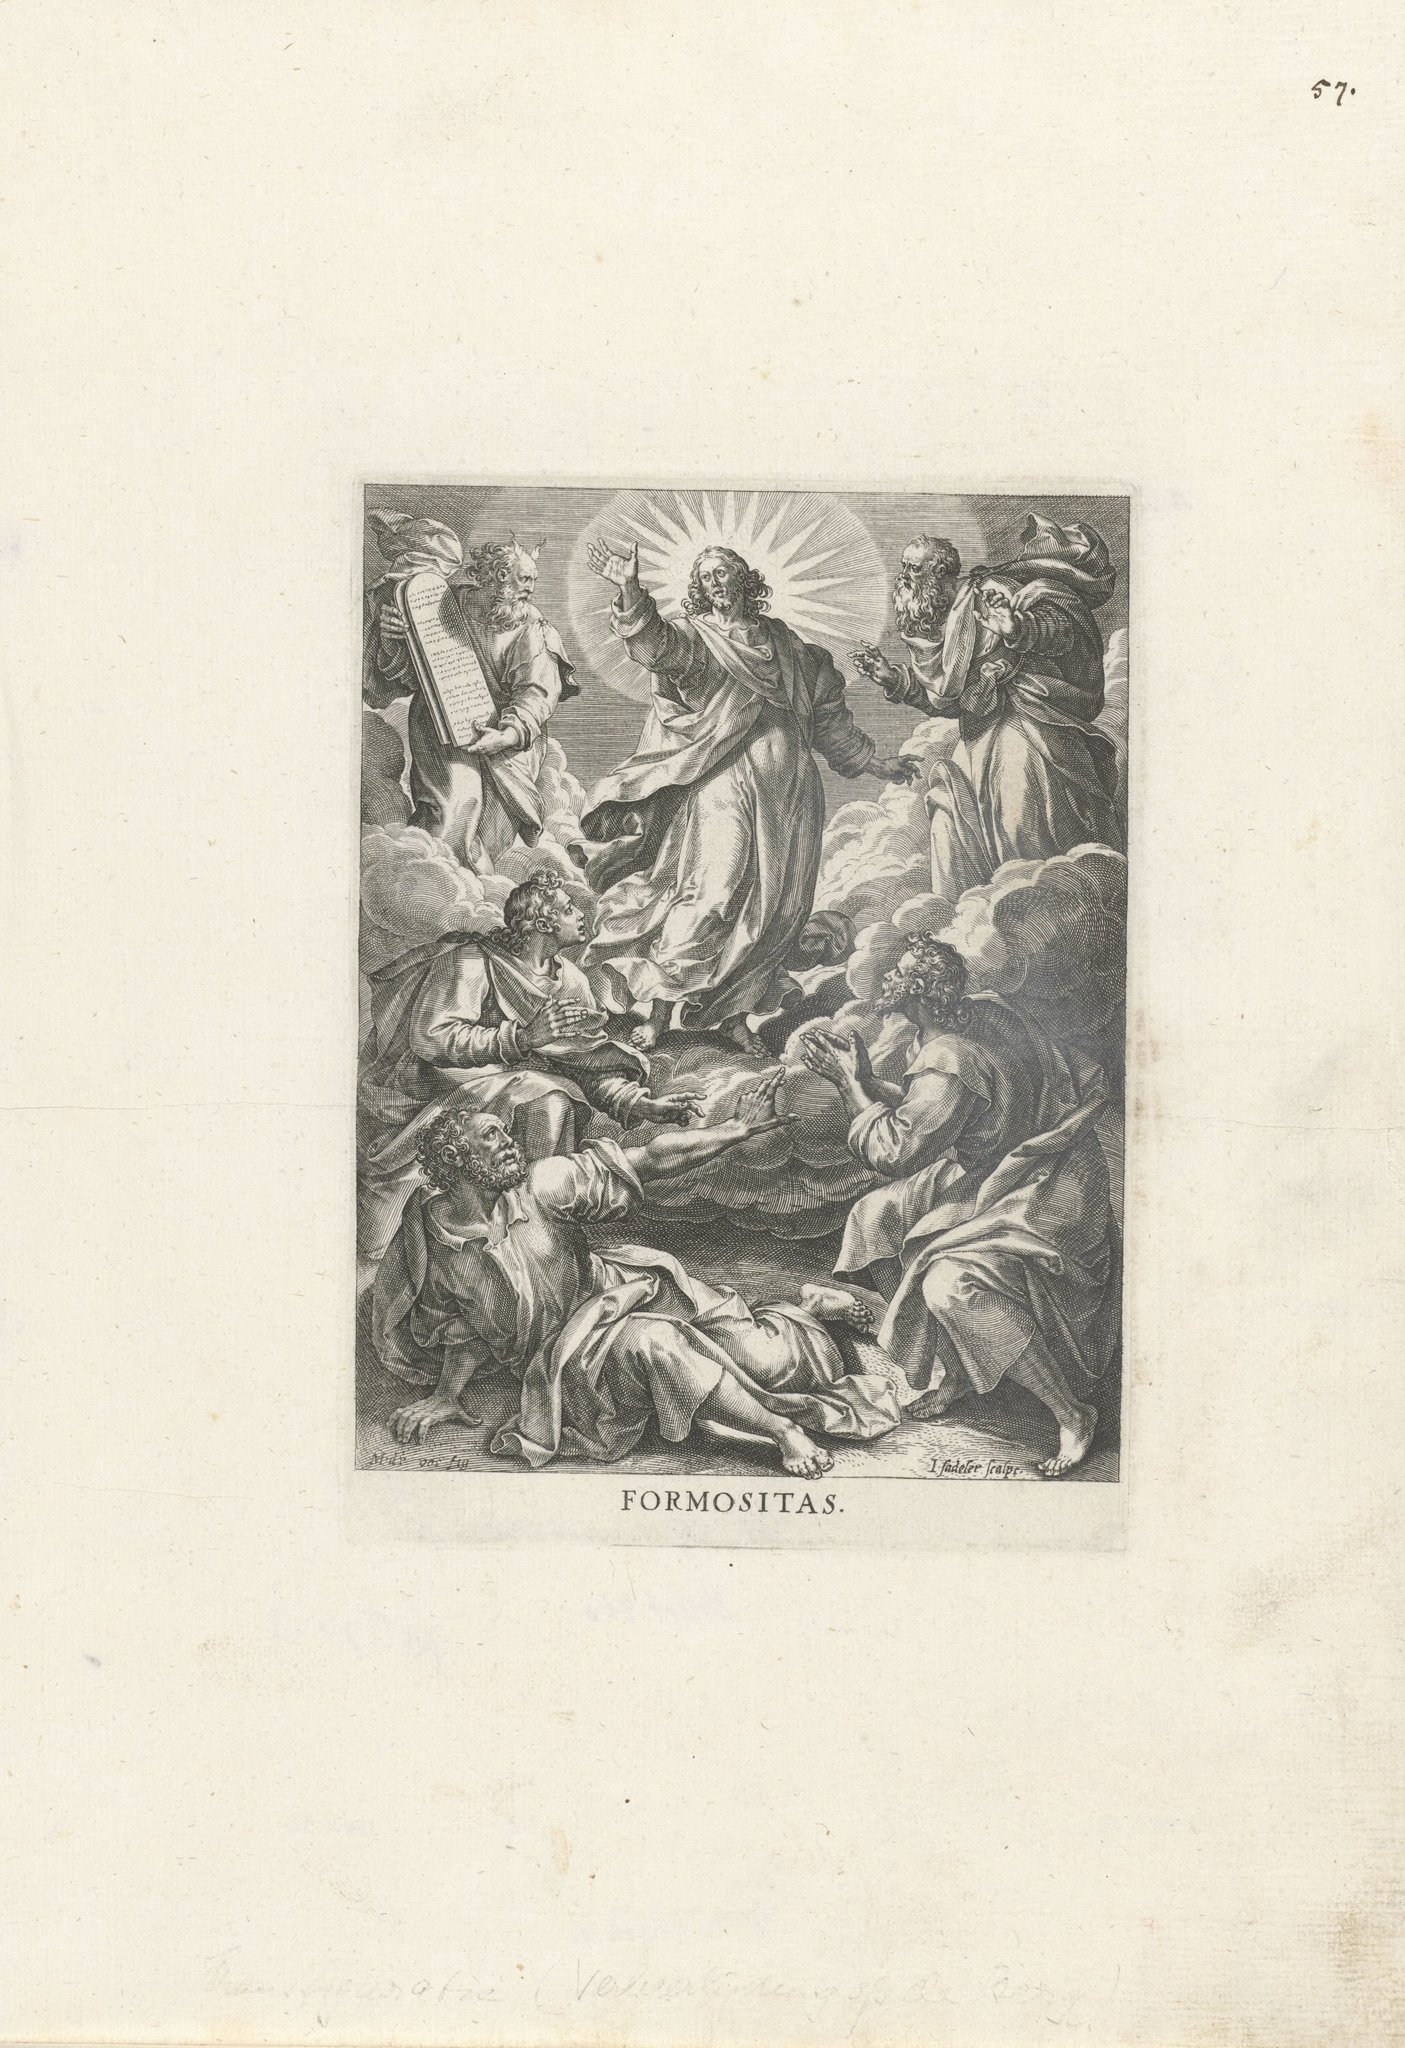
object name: print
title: Virtutes Iesu Christi Filii Dei Vivi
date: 1585-1588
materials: paper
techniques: engraving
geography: munich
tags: the sublime, the transfiguration: moses and elijah appear on either side of christ on mount tabor (matthew 17:1-13; mark 9:2-13; luke 9:28-36)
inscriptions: number: ‘57’, collector's mark: Lugt 2228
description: Christus vertoont zijn goddelijk wezen aan Petrus, Jakobus de Meerdere en Johannes. Hij is omgeven door hemelse stralen. Mozes (links) en Elia (rechts) verschijnen naast hem. De vijfde prent van een achtdelige serie met scènes uit het leven van Christus die zijn belangrijkste deugden verbeelden.